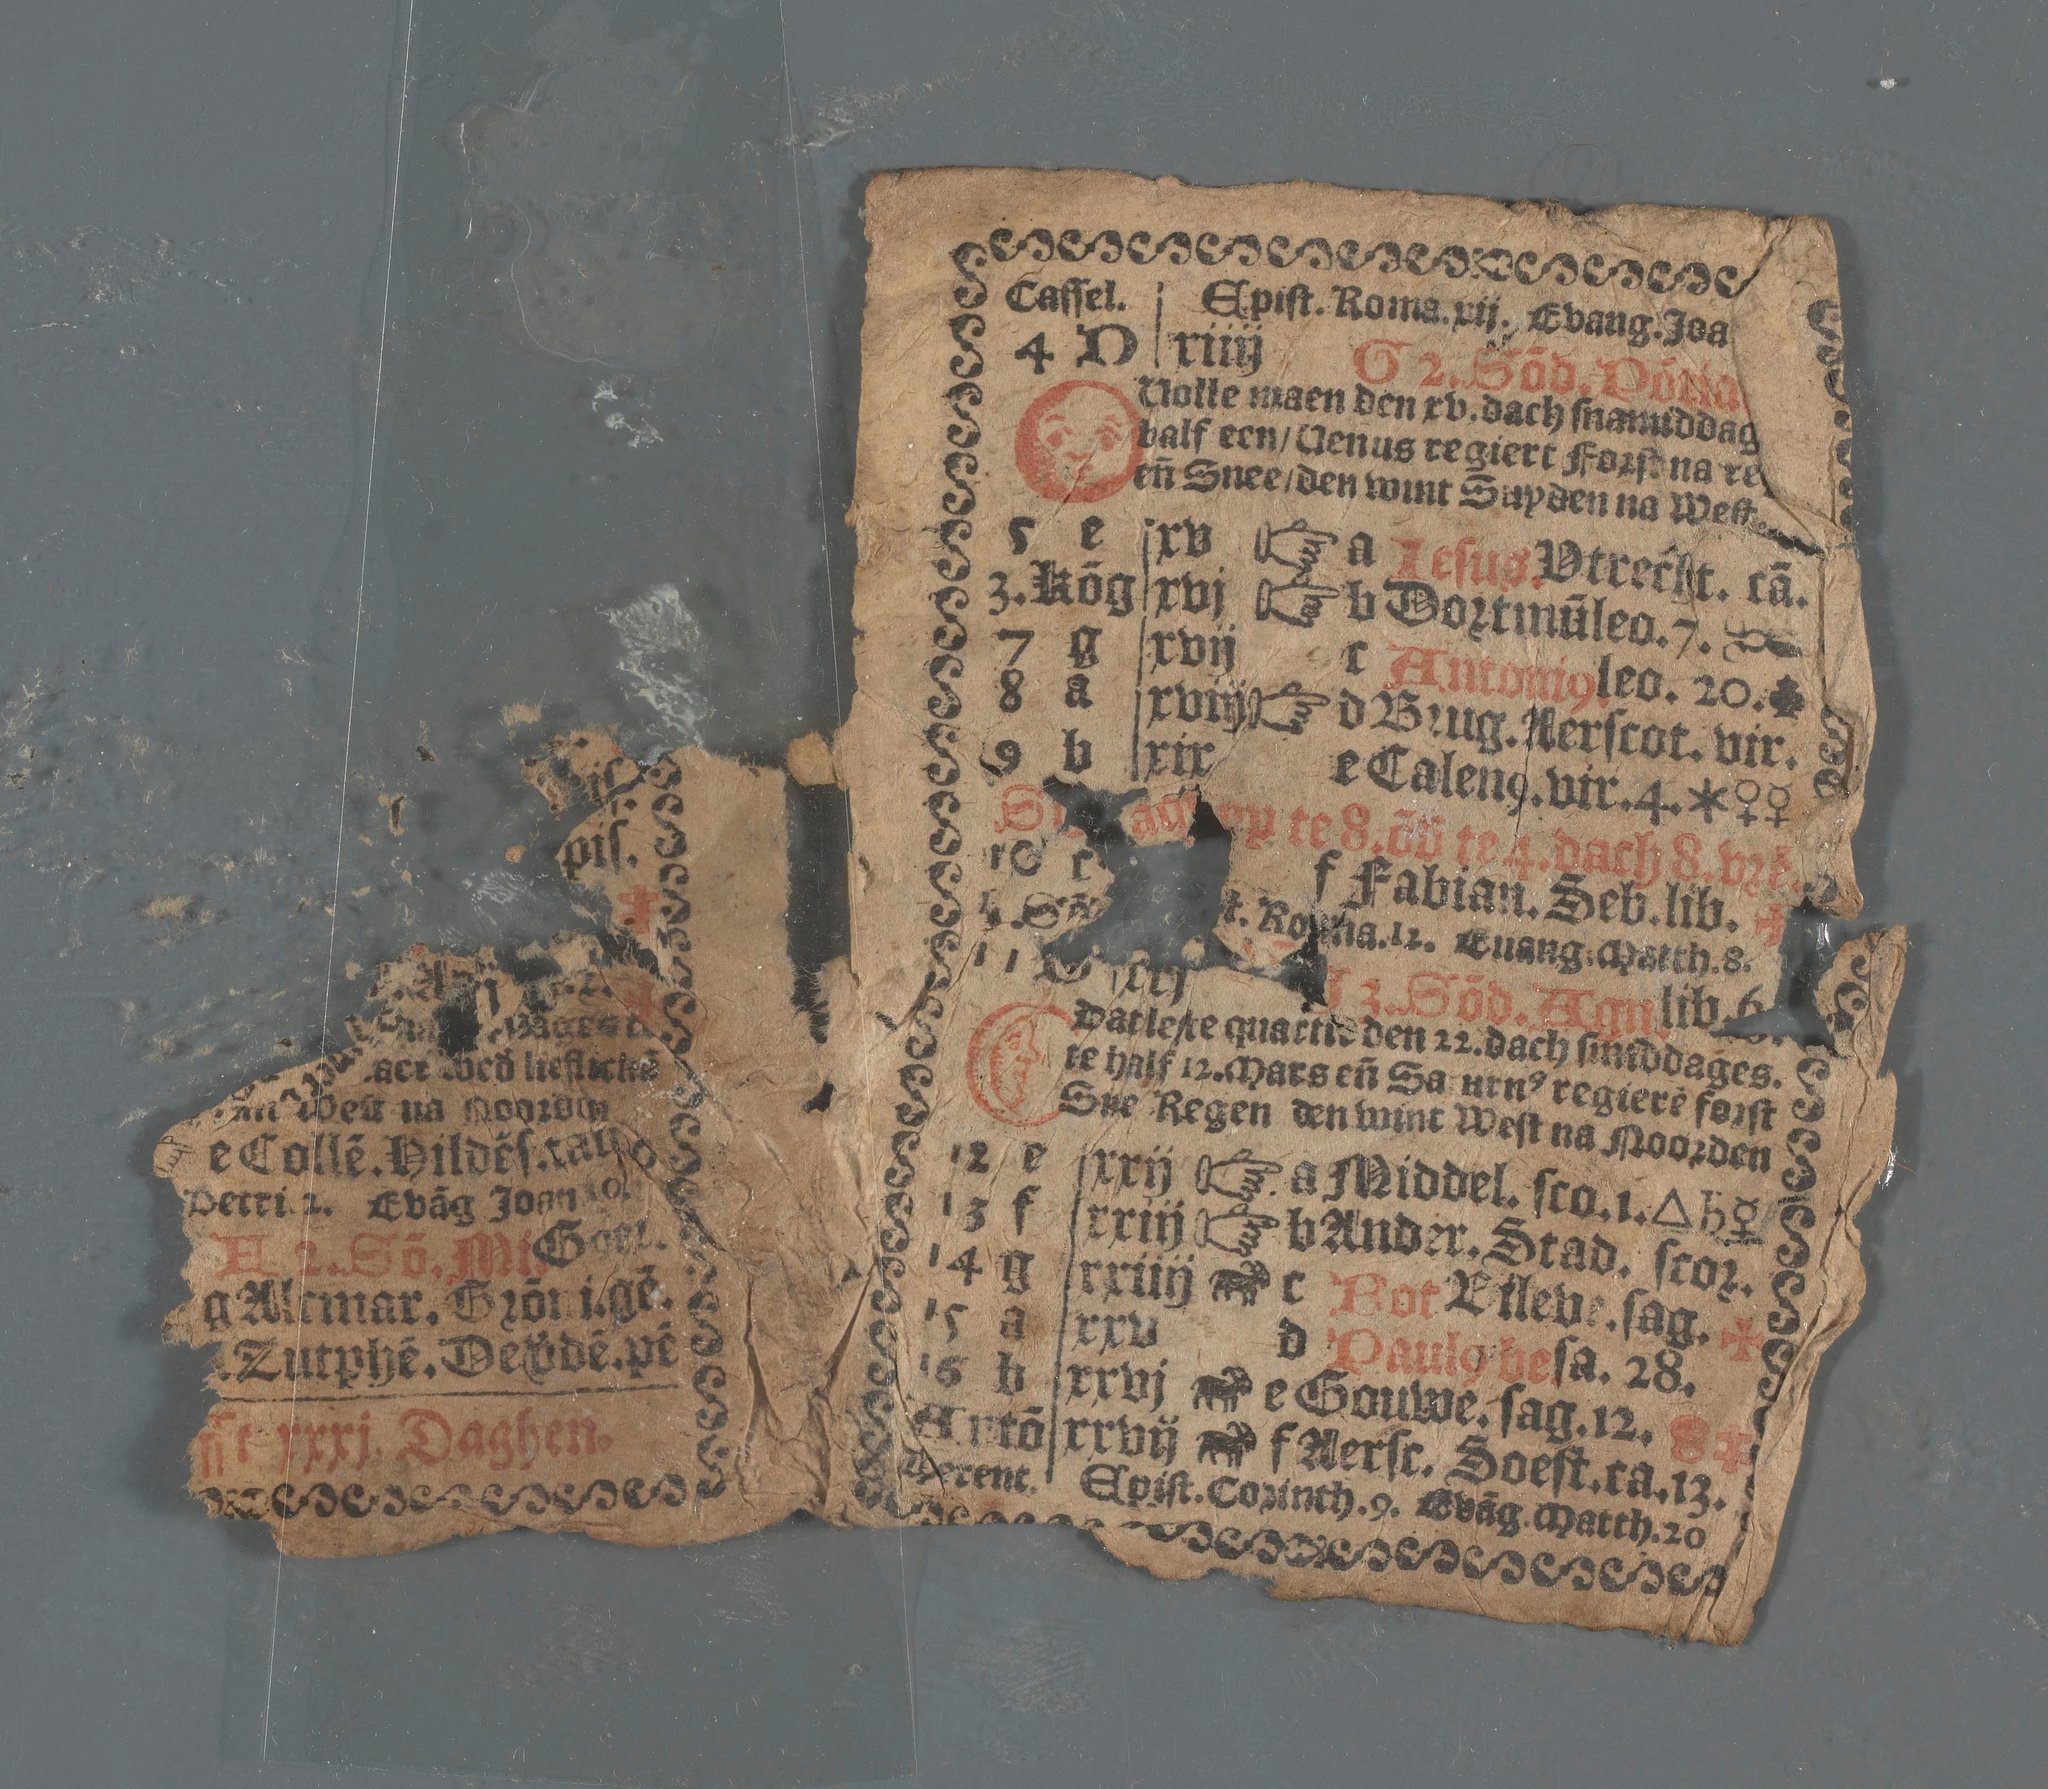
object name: almanac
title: Bladzijde uit een Deventer almanak voor het schrikkeljaar 1596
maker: Anonymous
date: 1596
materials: paper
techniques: printing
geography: enkhuizen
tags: willem barendsz., amsterdam, jacob van heemskerck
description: Bladzijde uit een Deventer almanak voor het schrikkeljaar 1596. Achter- en voorkant.